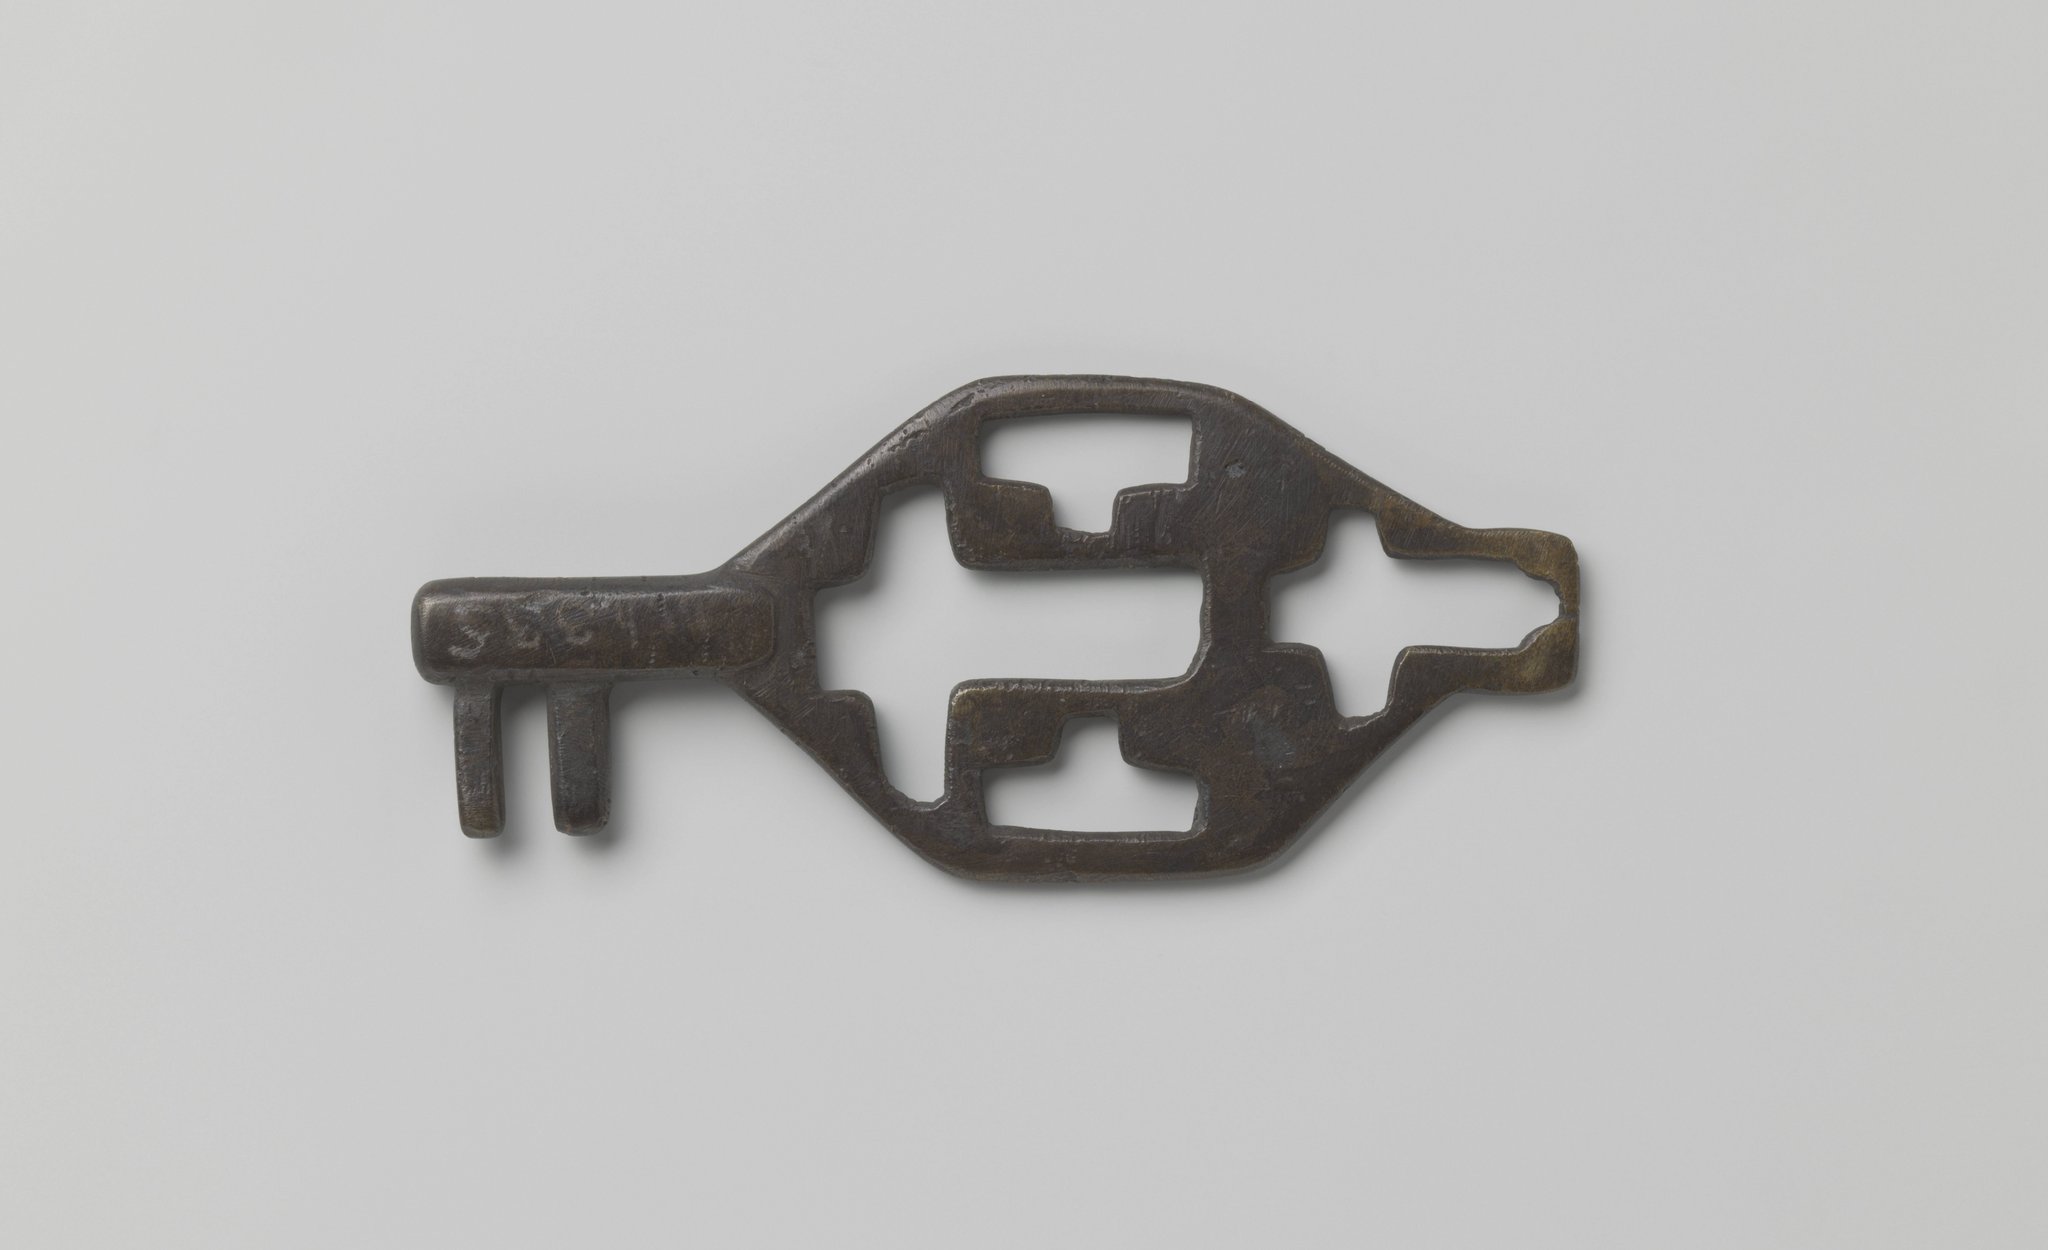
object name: key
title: Bisschopssleutel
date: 1400-1950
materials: bronze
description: Platte sleutel zgn. "bisschopssleutel" met twee omgekeerde kruisvormen in de zeshoekige greep uitgehakt en met een tweeledige baard.